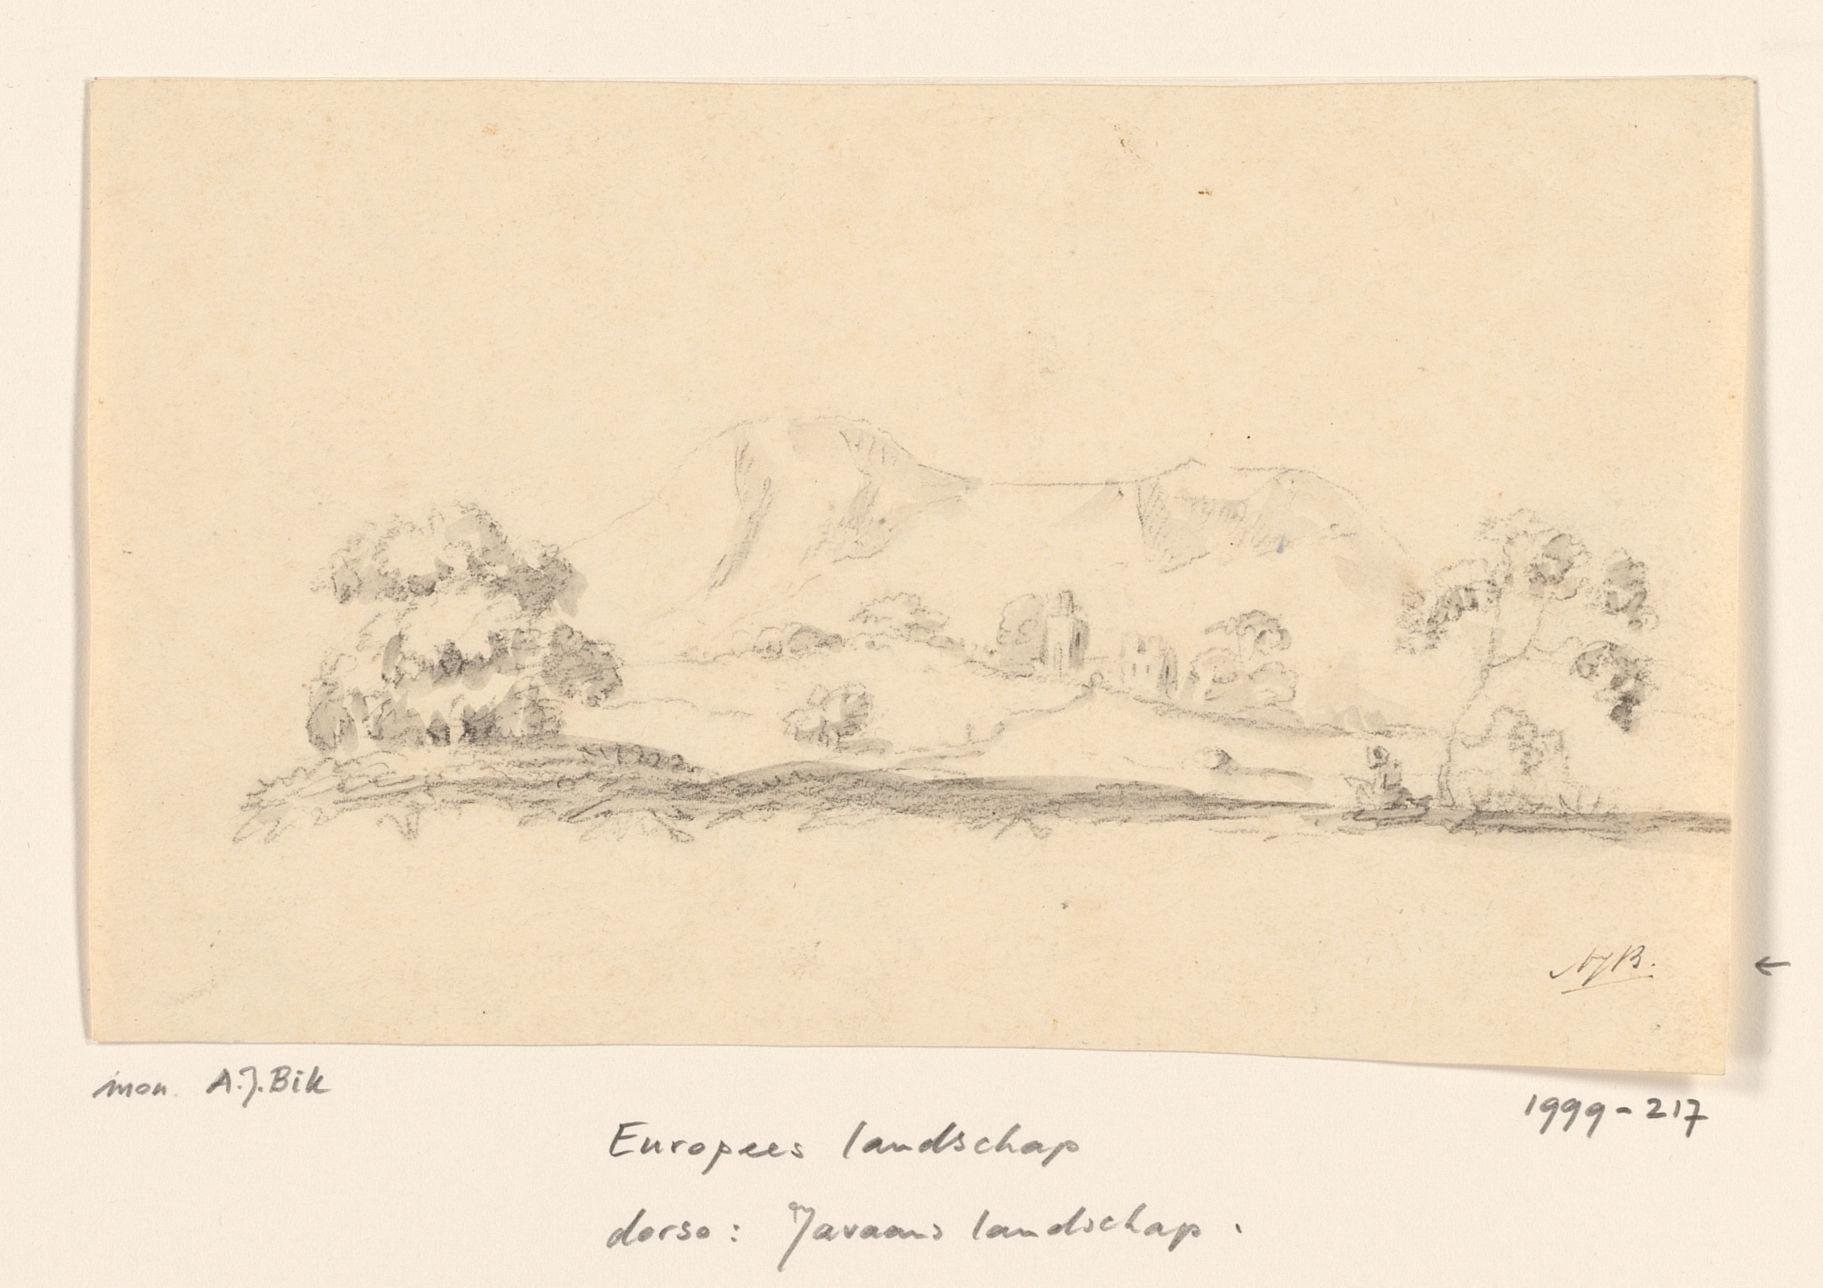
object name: topographical view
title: Europees landschap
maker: adrianus johannes bik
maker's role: draughtsman, print maker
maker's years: 1790-1872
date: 1816-1846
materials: paper, pencil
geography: java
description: artikel over deze collectie in Bulletin van het Rijksmuseum 49 [2001], nr. 4, pp 342 e.v.